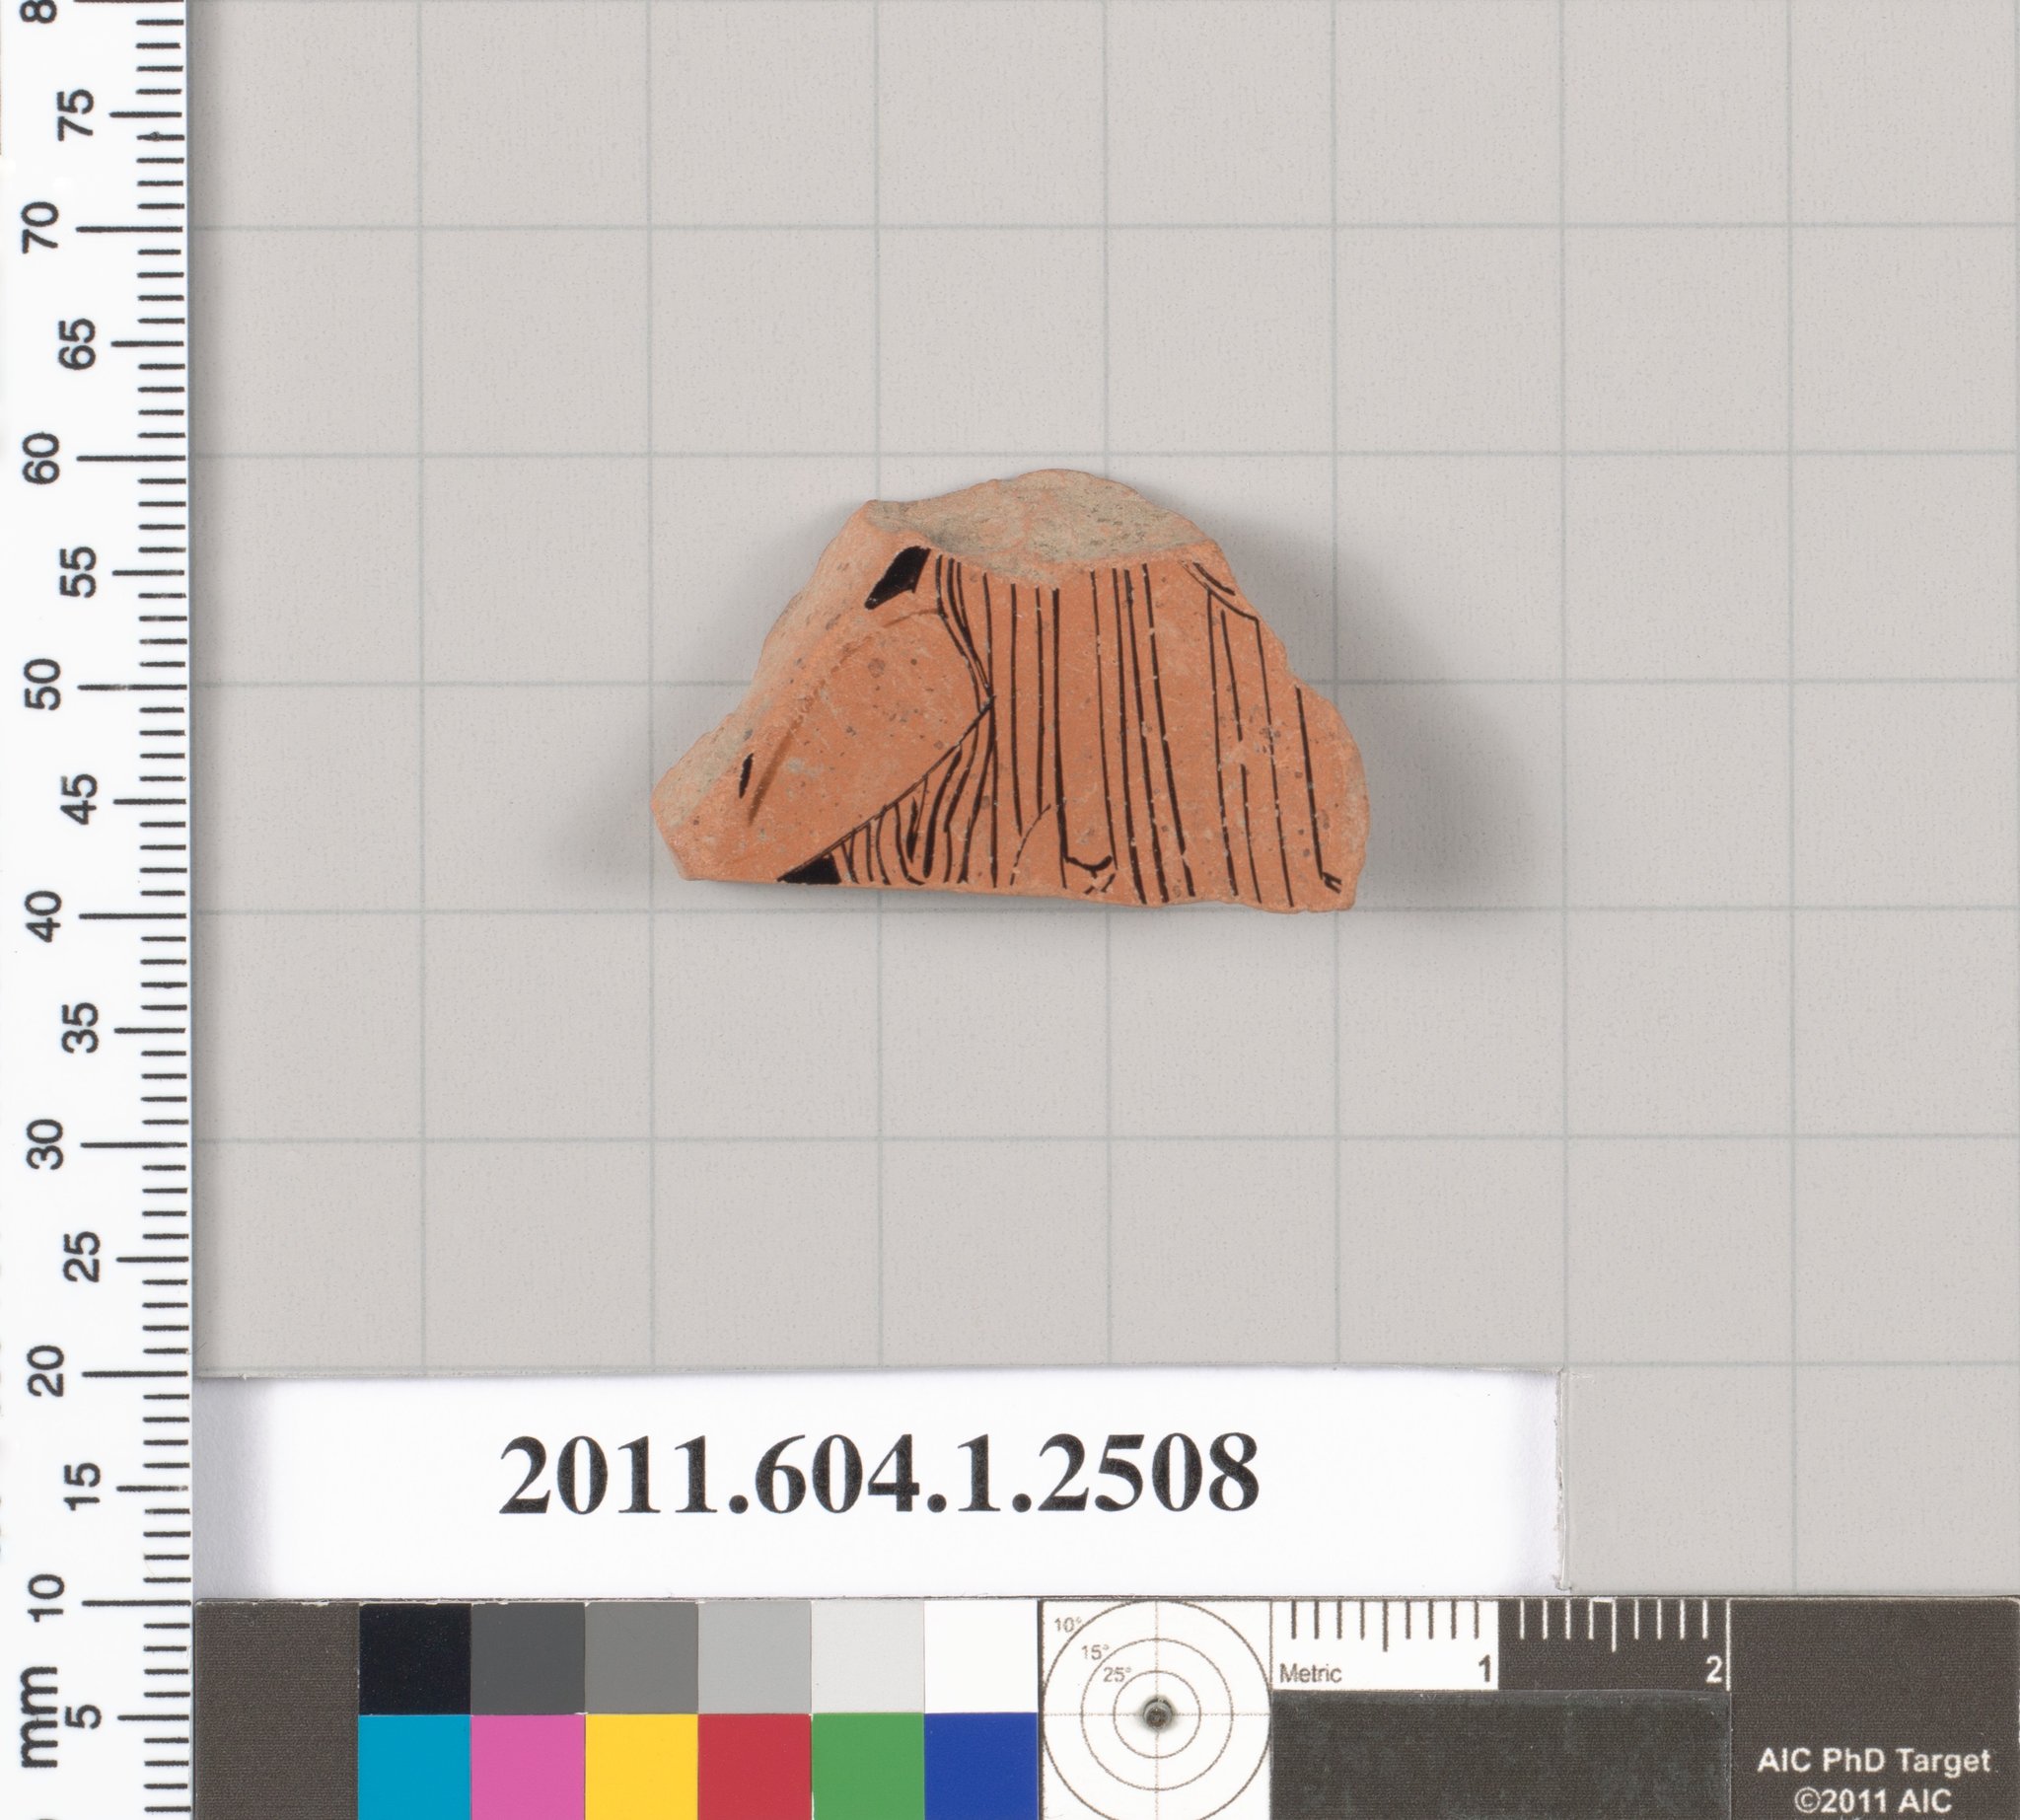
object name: kylix fragment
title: Terracotta fragment of a kylix (drinking cup)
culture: greek, attic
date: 490-480 BCE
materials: terracotta